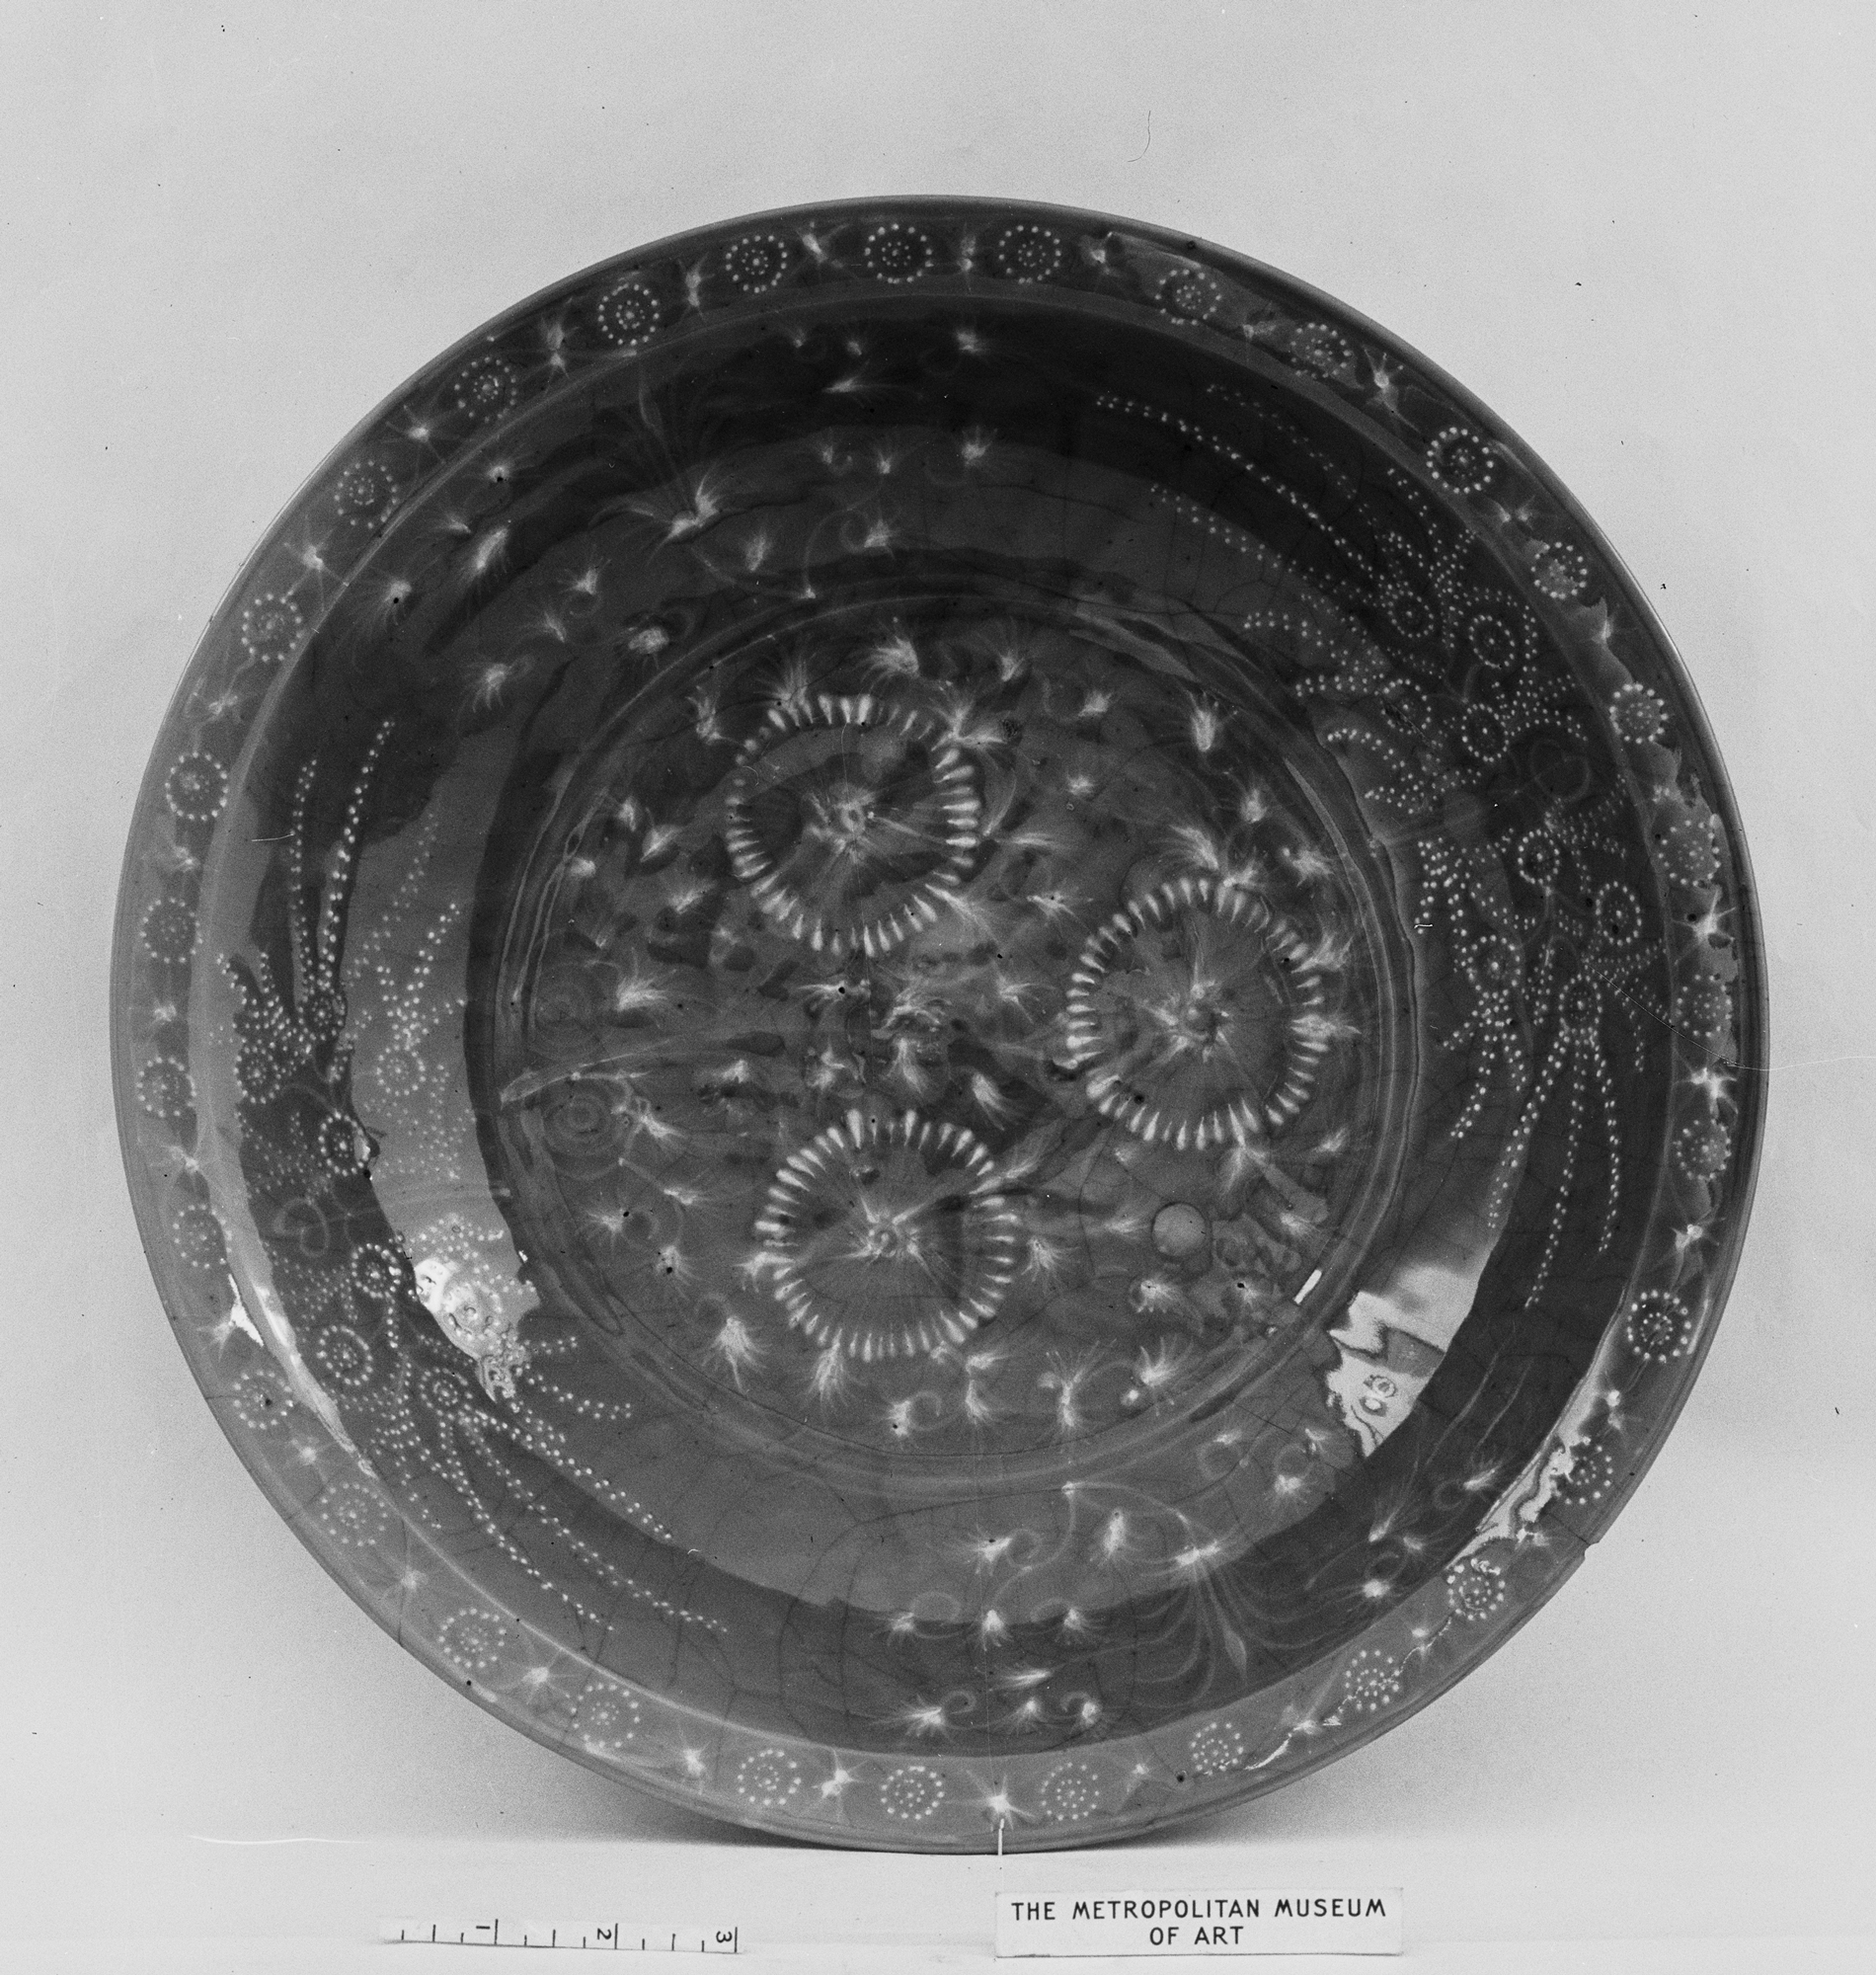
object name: plate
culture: chinese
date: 1567-1633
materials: glaze, stoneware